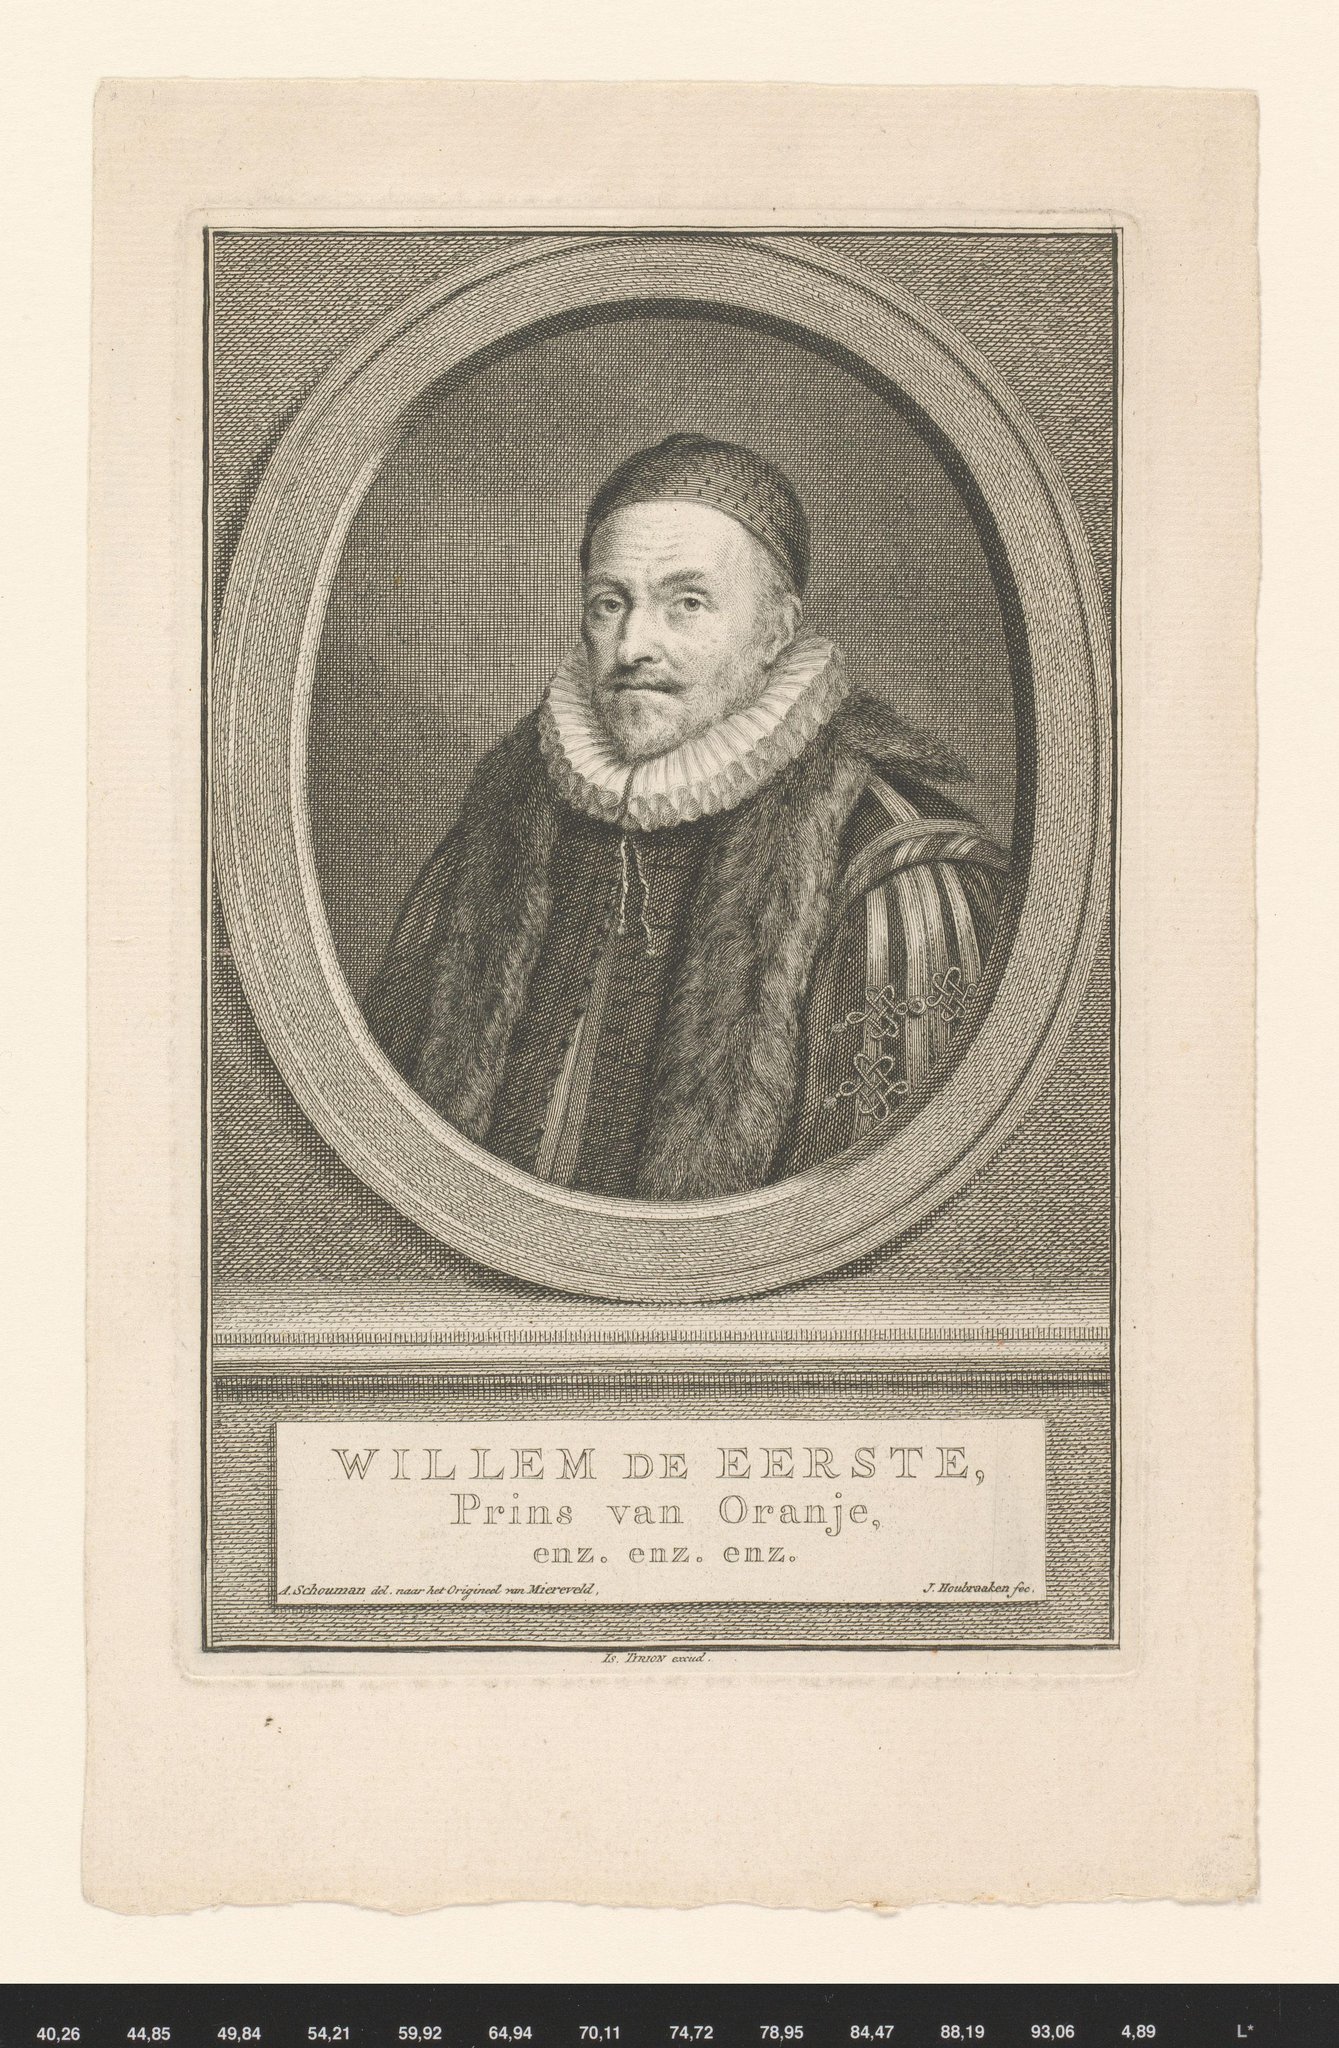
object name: print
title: Portret van Willem I van Oranje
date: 1752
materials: paper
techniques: engraving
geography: amsterdam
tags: william i (prince of orange), historical persons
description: Prent waarschijnlijk uit: Wagenaar, Jan. Vaderlandsche historie. Amsterdam: Isaak Tirion, 1752, dl. 7.